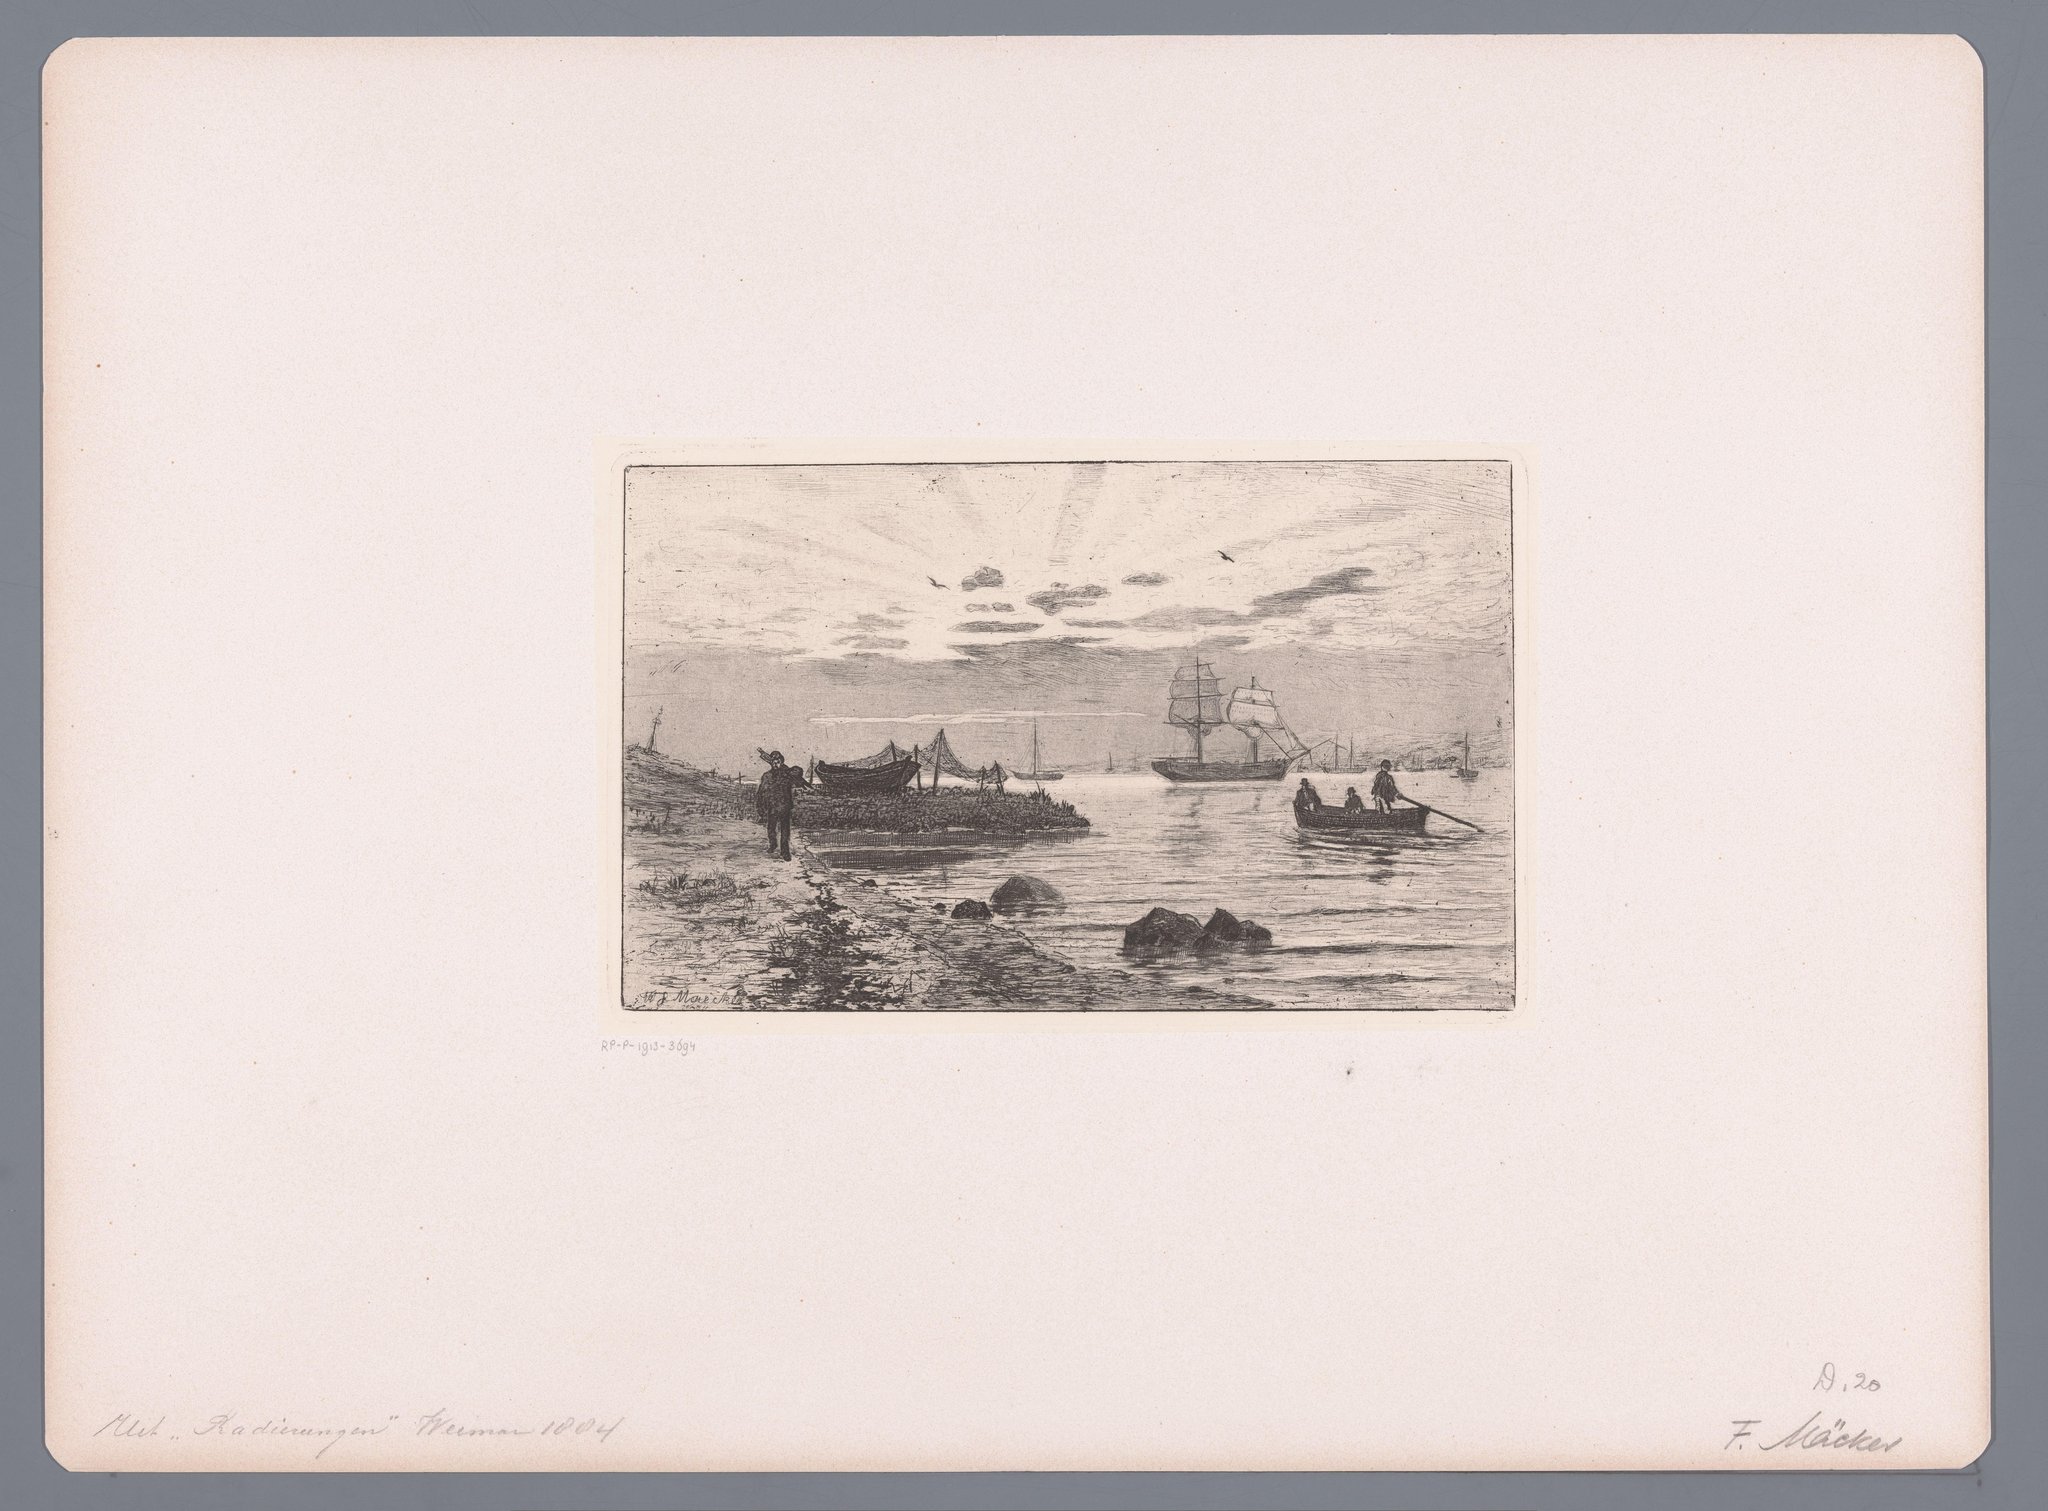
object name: print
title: Kustlandschap met zeil- en vissersboot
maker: franz maecker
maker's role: print maker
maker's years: 1855-1913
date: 1884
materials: paper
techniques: etching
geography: germany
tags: ships (in general), coast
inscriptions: collector's mark: Lugt 2228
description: Uit: Radierungen, herausgegeben von der Gesellschaft für Radierkunst zu Weimar. Jaargang 1884.